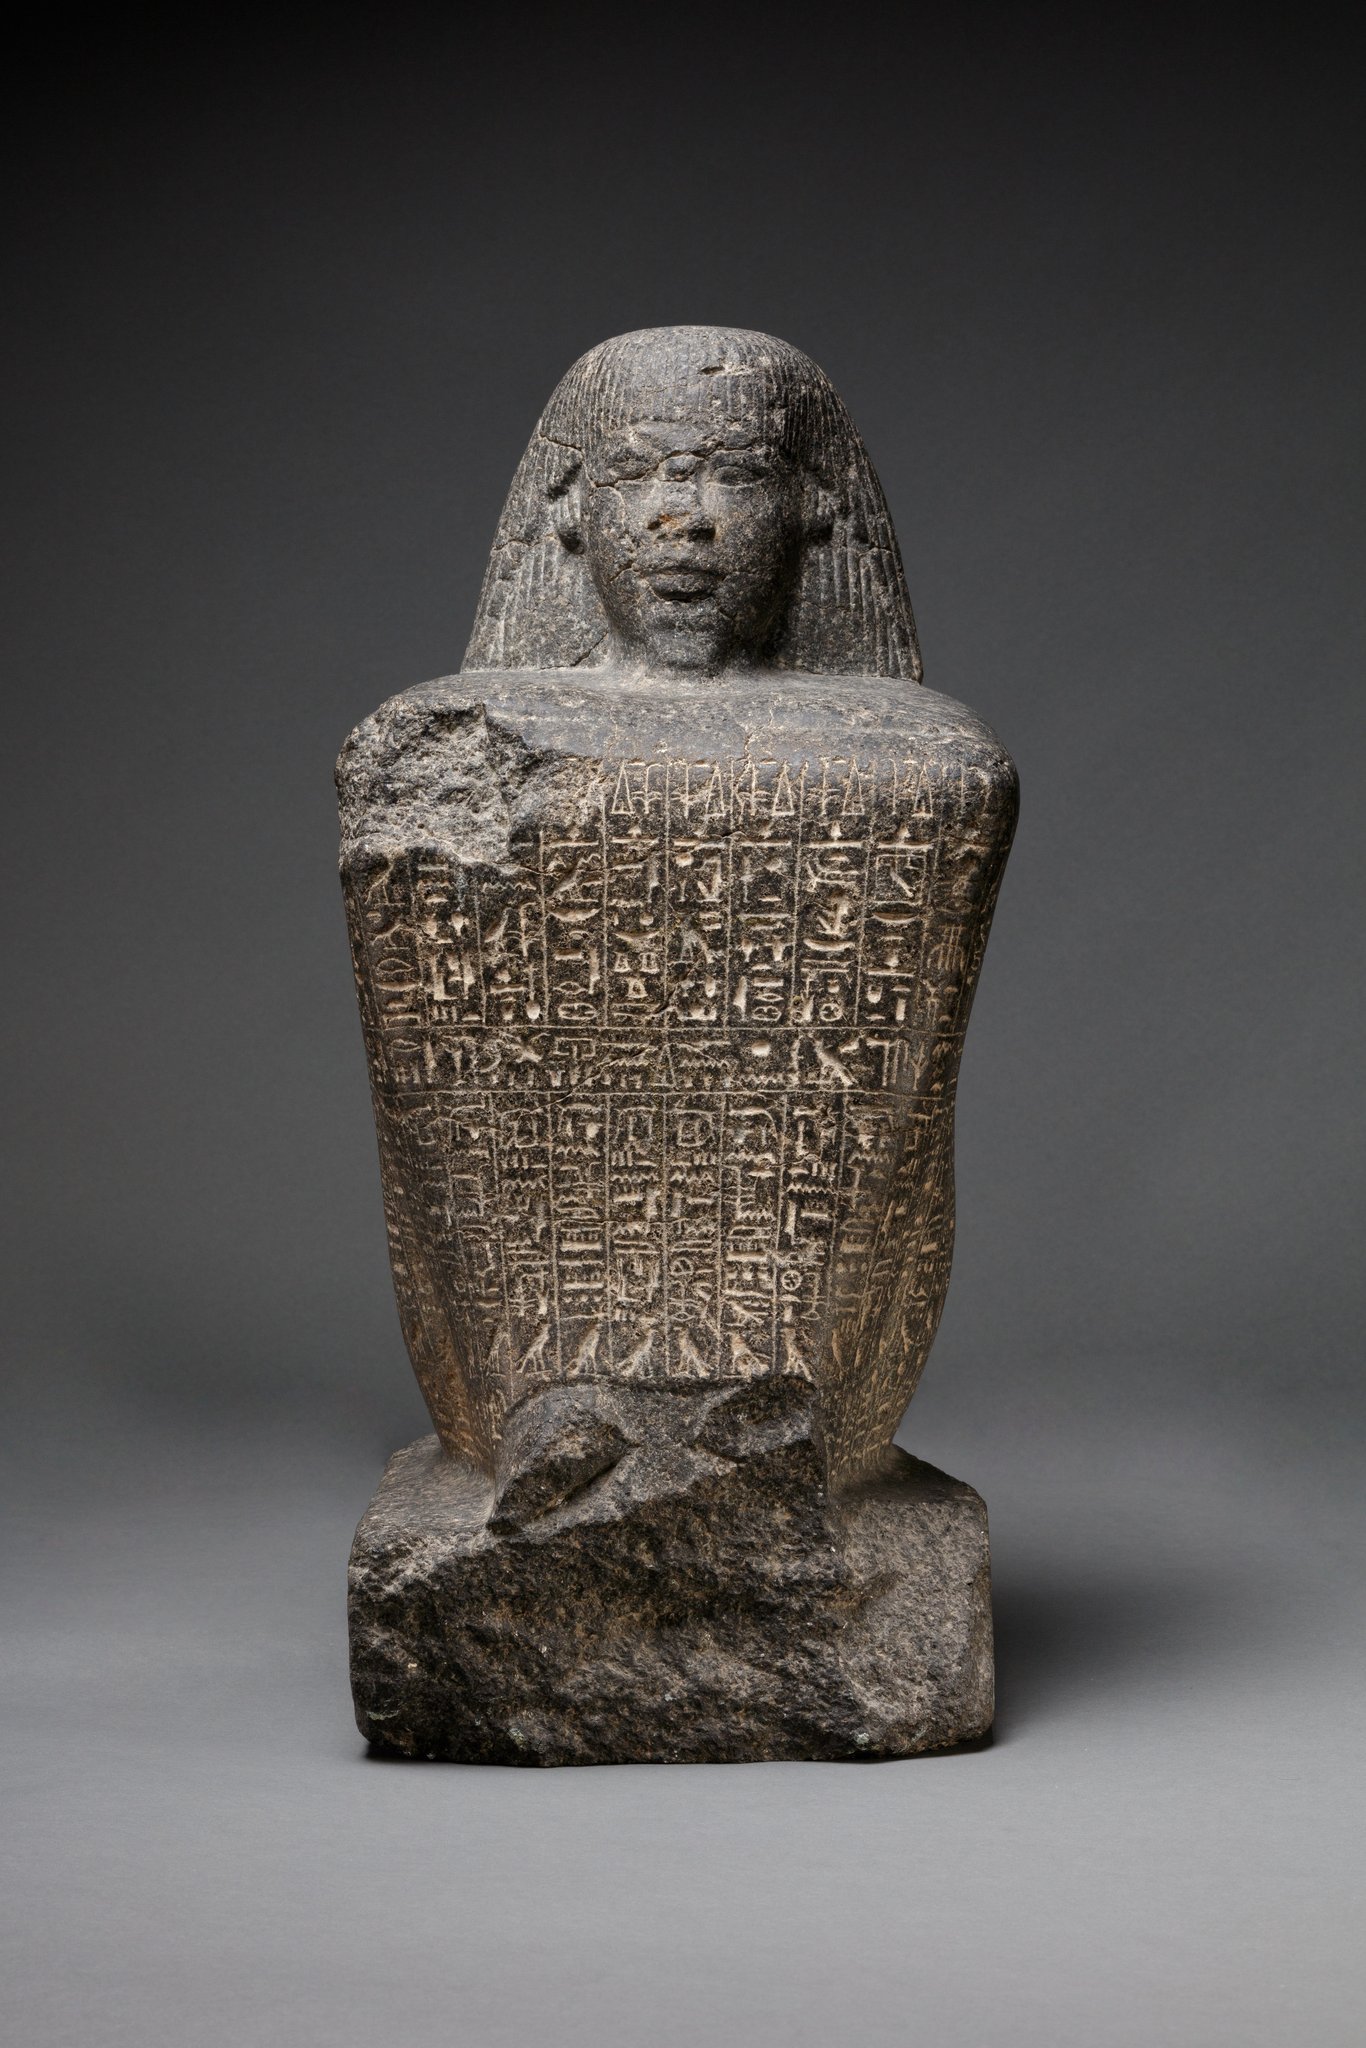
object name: block statue, hor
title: Block statue of Hor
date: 1550-1295 BCE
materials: granite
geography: northern upper egypt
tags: men,hieroglyphs